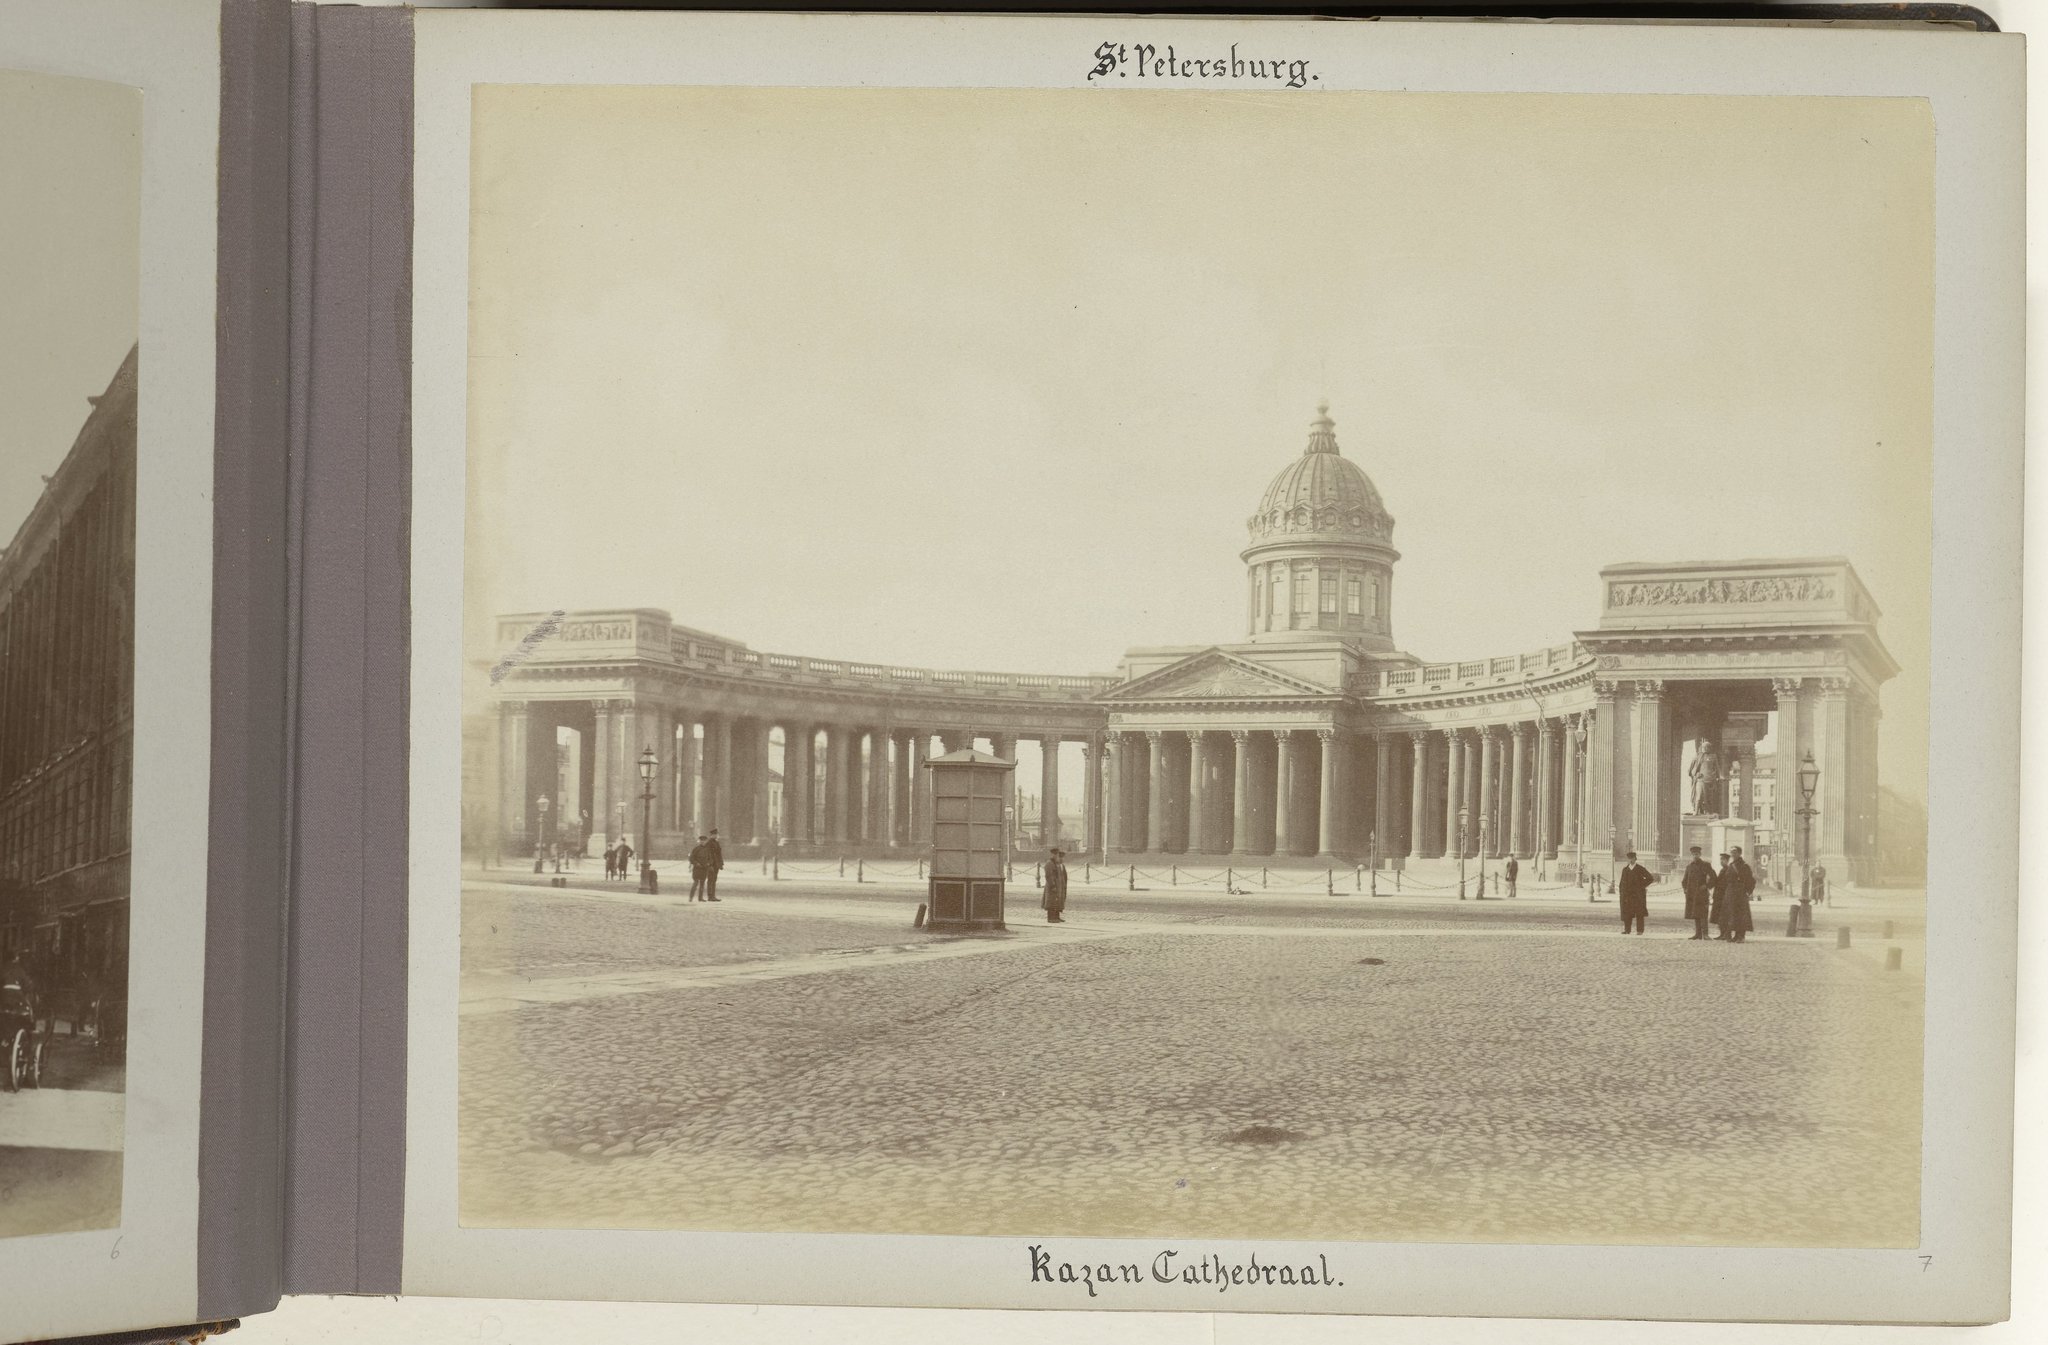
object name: photograph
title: Kazankathedraal in Sint Petersburg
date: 1898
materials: paper, photographic support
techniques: albumen print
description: De Kazankathedraal in Sint Petersburg, ontworpen door Andrej Voronichin waarbij het ontwerp gebasseerd is op dat van de Sint Pieter. De Kathedraal is vernoemd naar de Icoon van de Madonna van Kazan